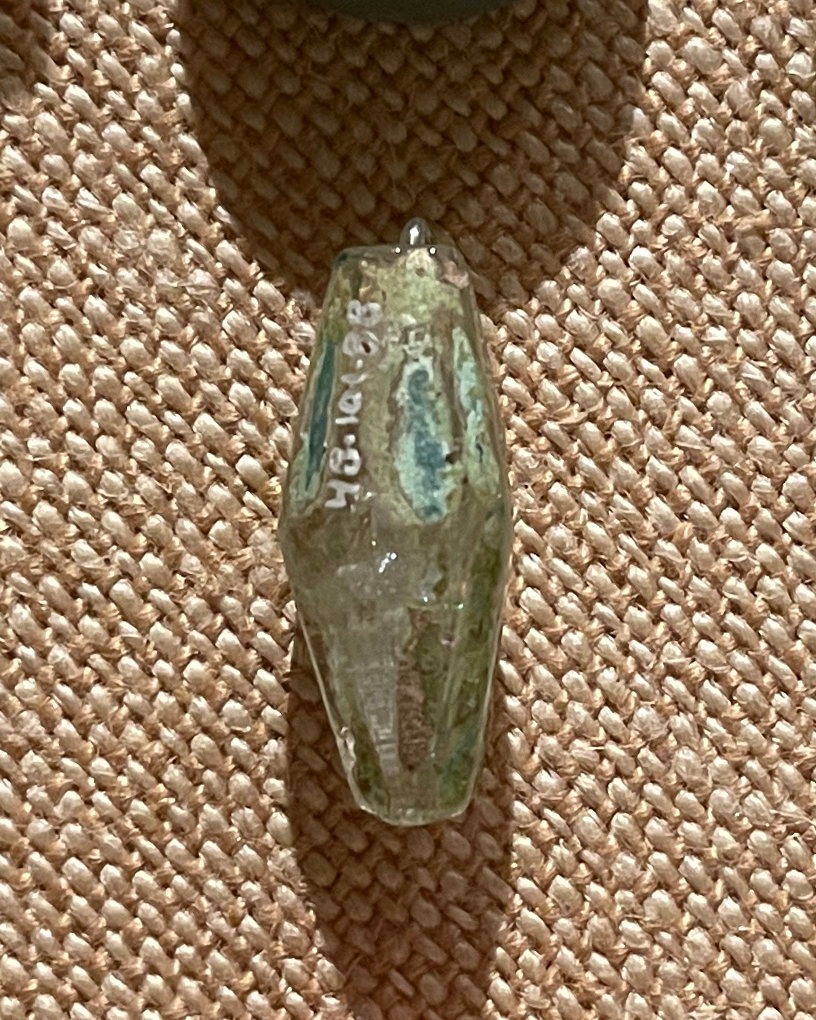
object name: bead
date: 701-1300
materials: quartz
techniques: cutting, glazing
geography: iran